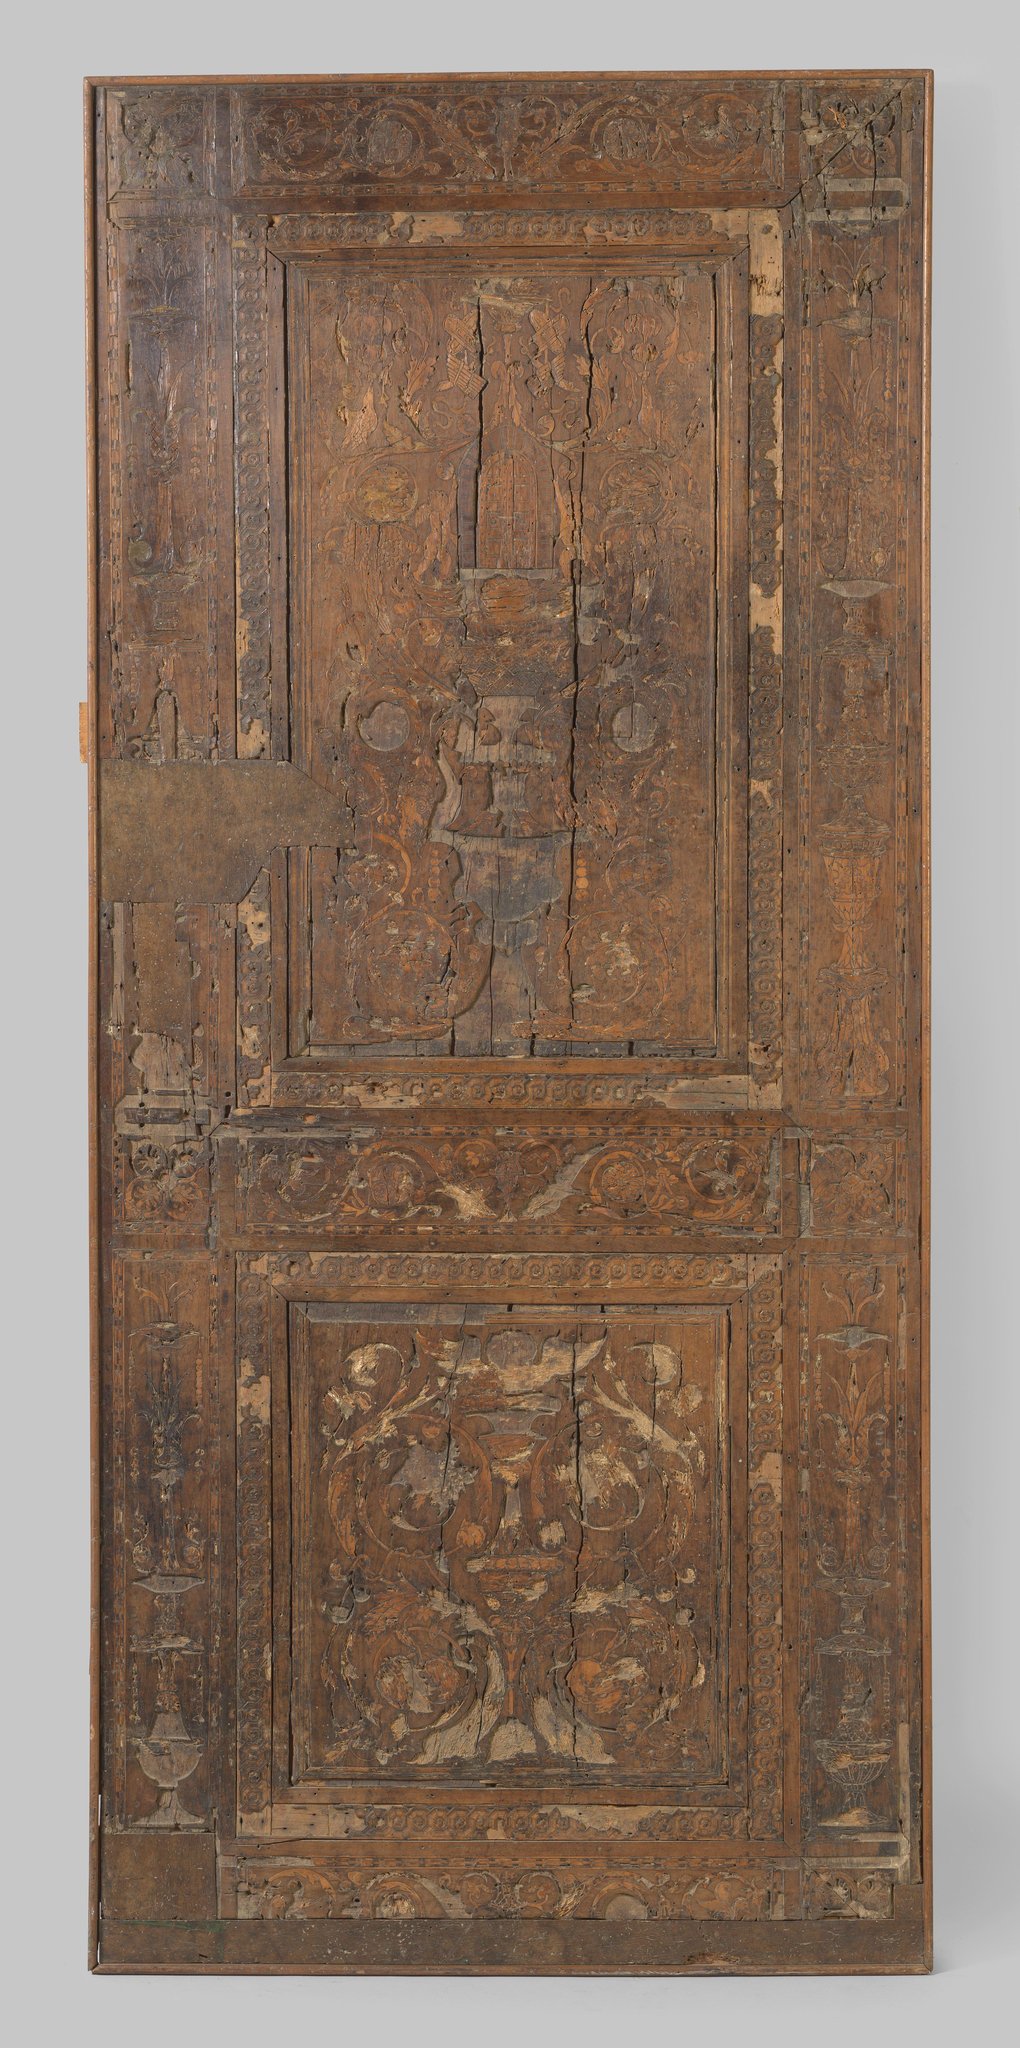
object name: deurpaneel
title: Paneel met wapen zijdeweversgilde te Florence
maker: Anonymous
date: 1440-1460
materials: wood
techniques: intarsia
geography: florence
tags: florence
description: Paneel van een notenhouten deur, bevestigd op vurenhout, versierd met intarsia. Het paneel heeft een tweedeling en zowel de twee vakken als de omlijsting vertonen arabesken en kandelabermotieven. Het bovenvak geeft het wapen van het zijdeweversgilde te Florence weer.